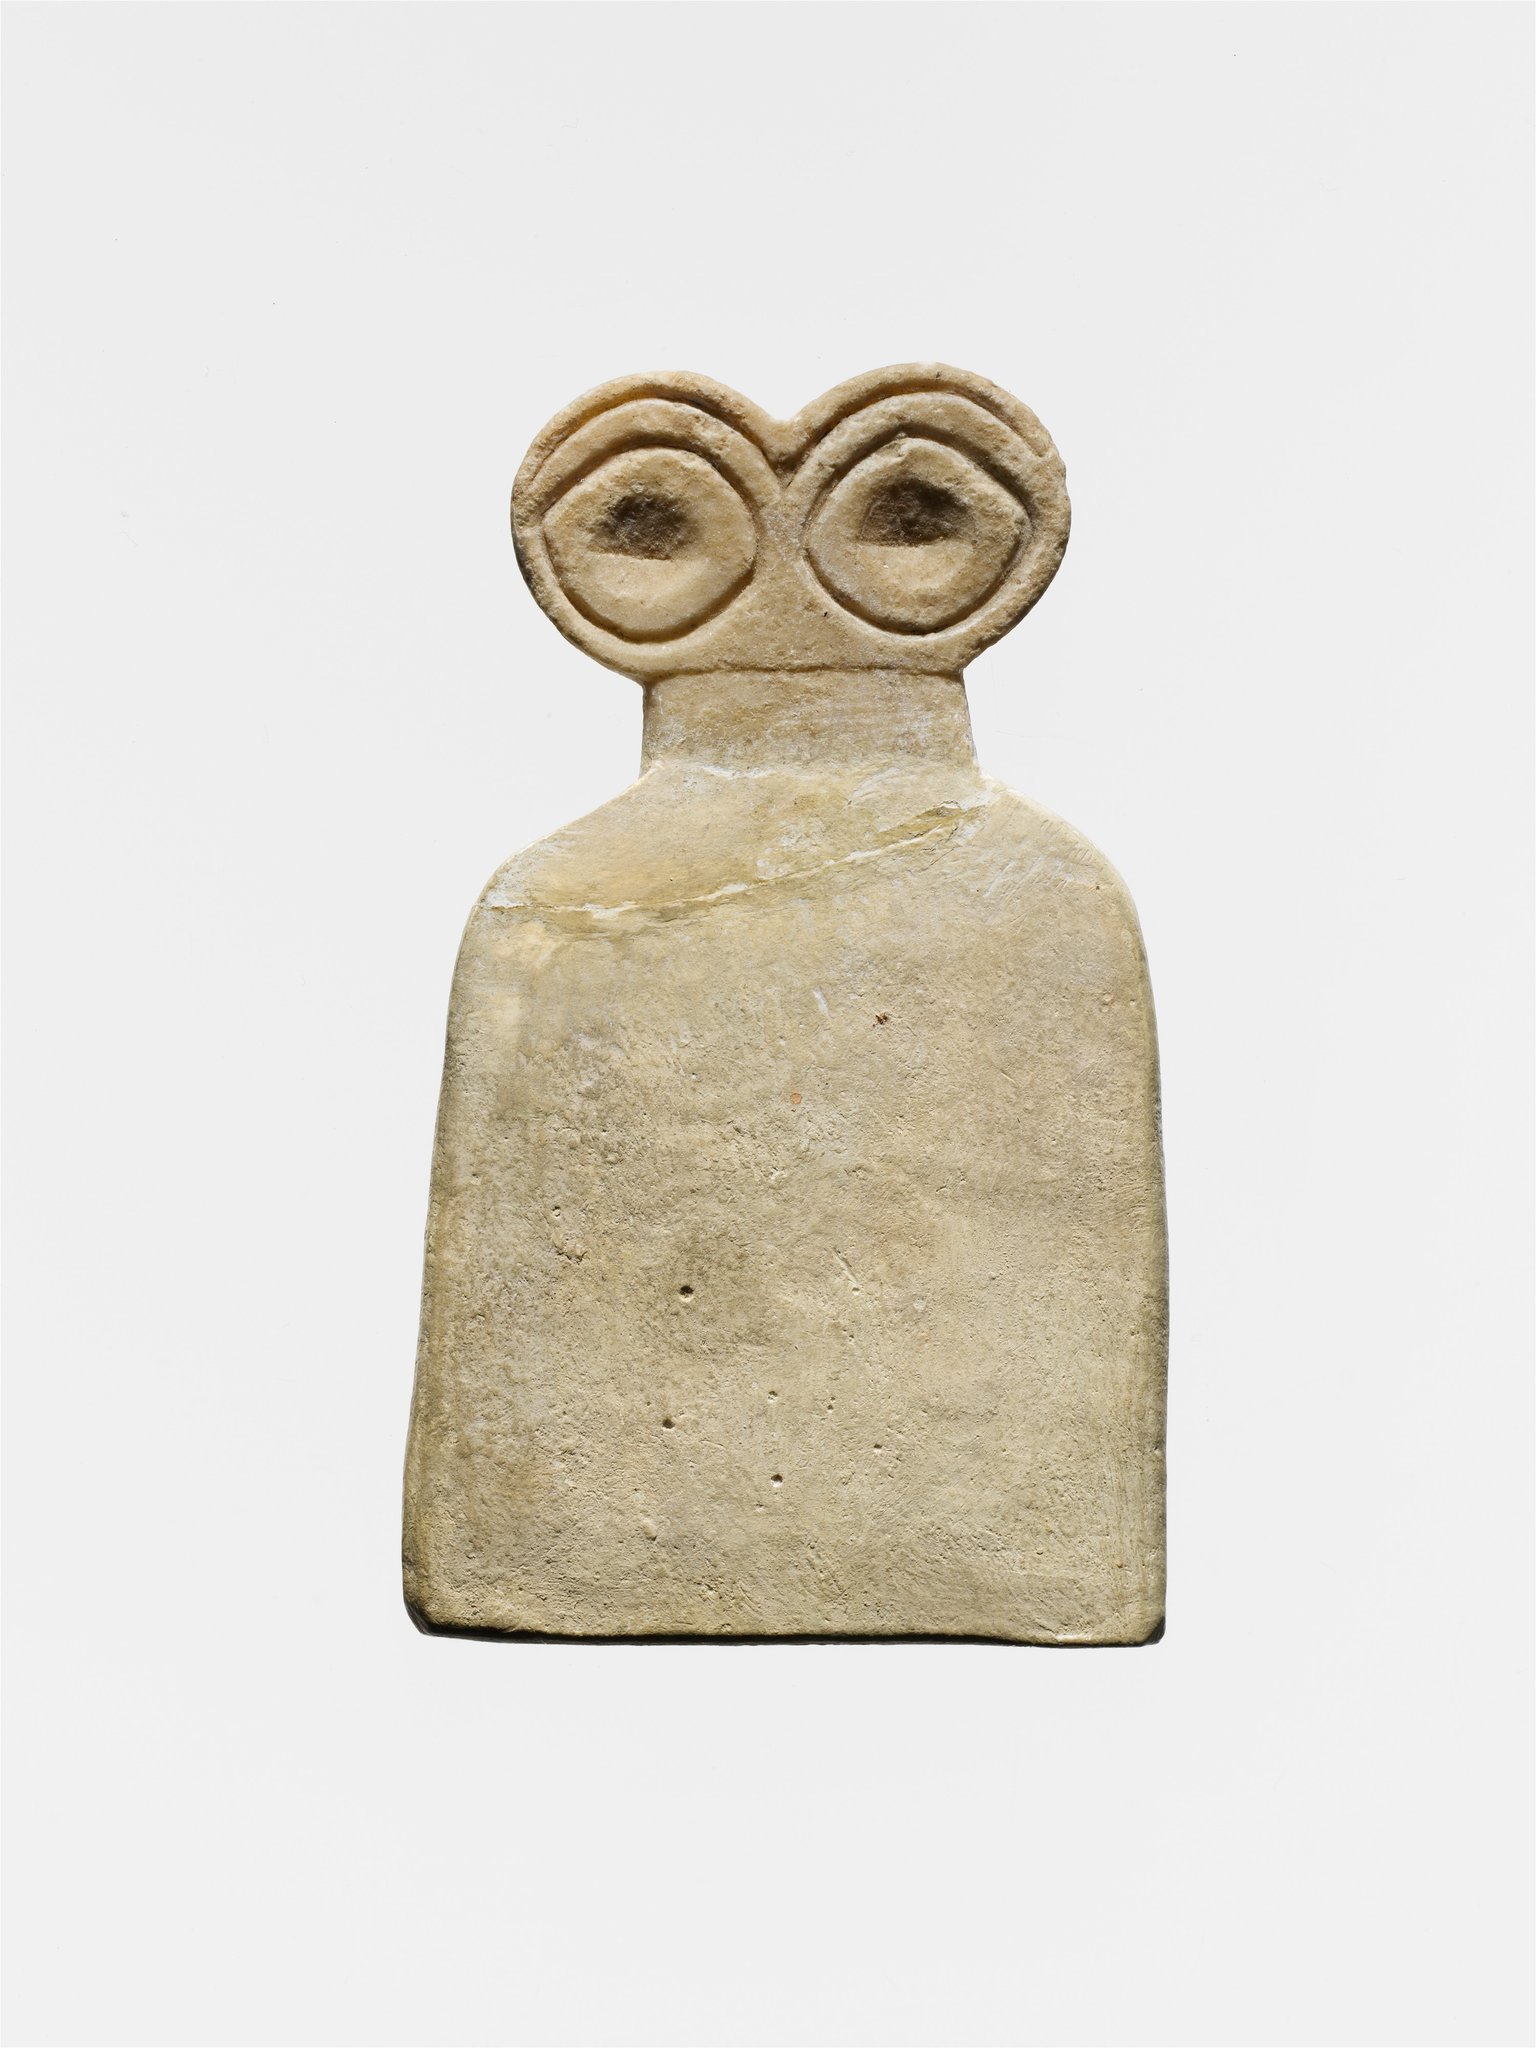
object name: sculpture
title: Eye idol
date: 3700-3500 BCE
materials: alabaster, gypsum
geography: syria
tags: eyes